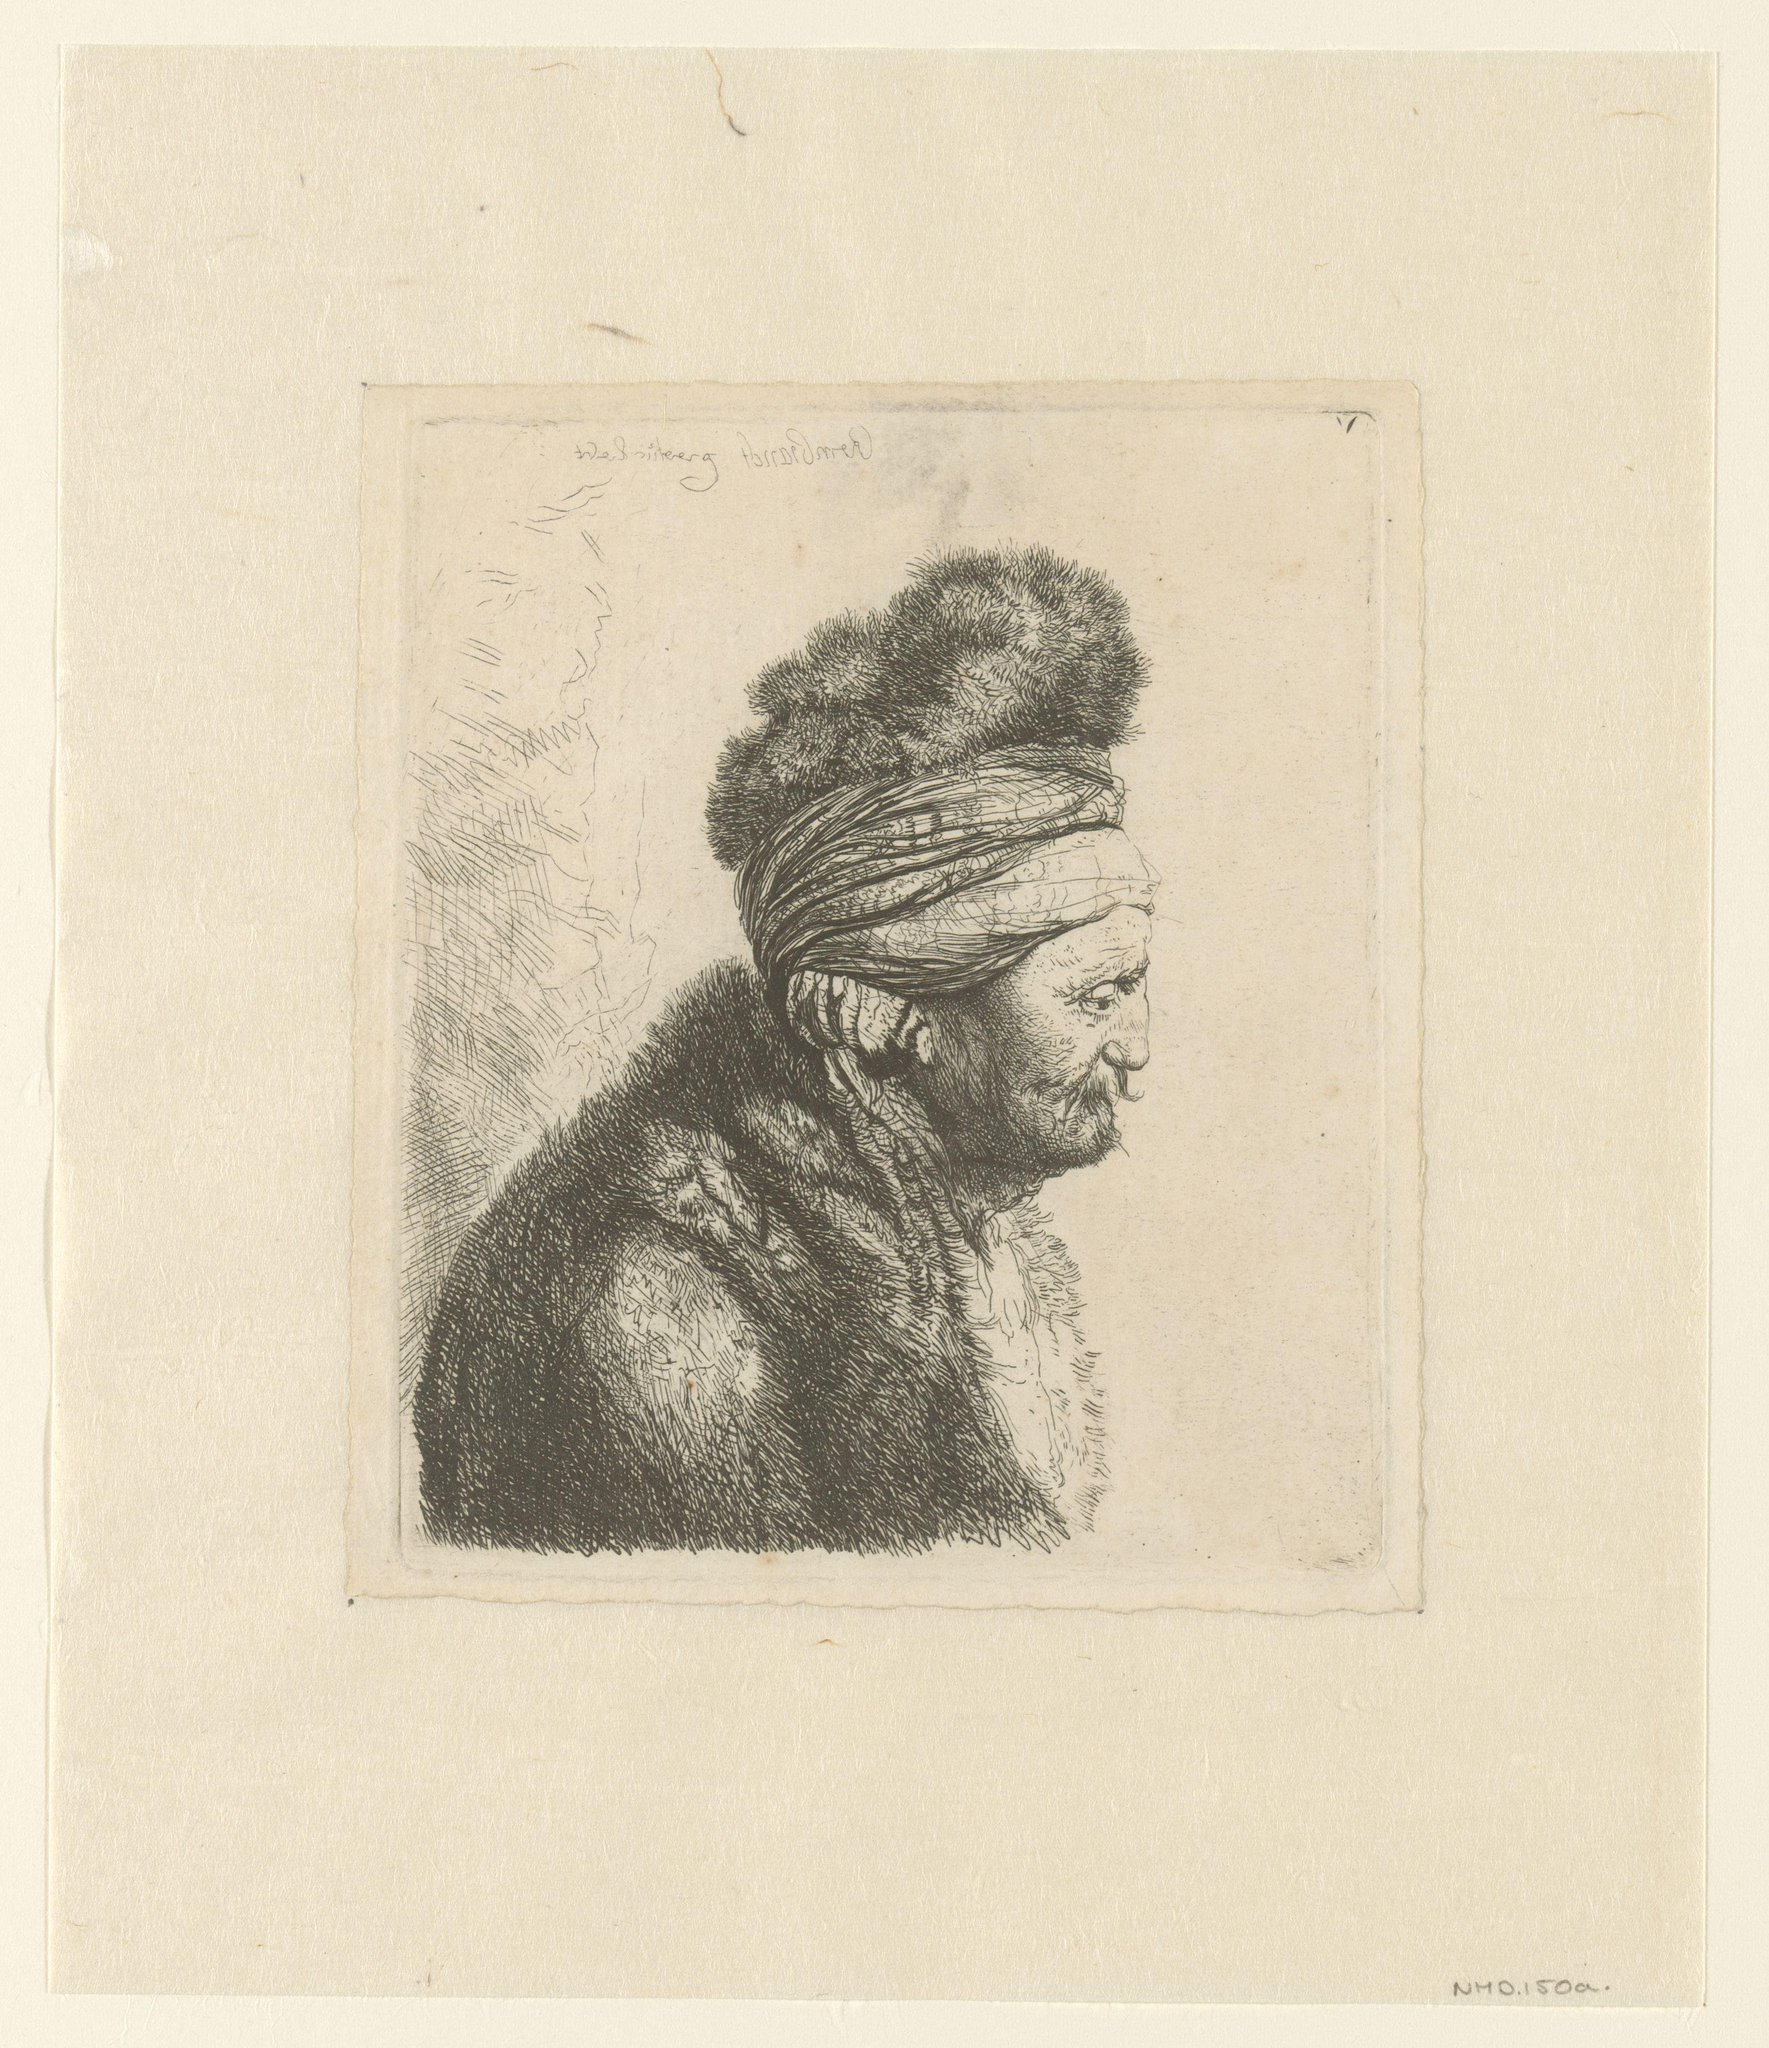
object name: print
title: The second oriental head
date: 1717-1764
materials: paper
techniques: etching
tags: old man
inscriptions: collector's mark: Lugt 2760, collector's mark: Lugt 2228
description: Spiegelbeeldige kopie naar de gelijknamige prent van Rembrandt.